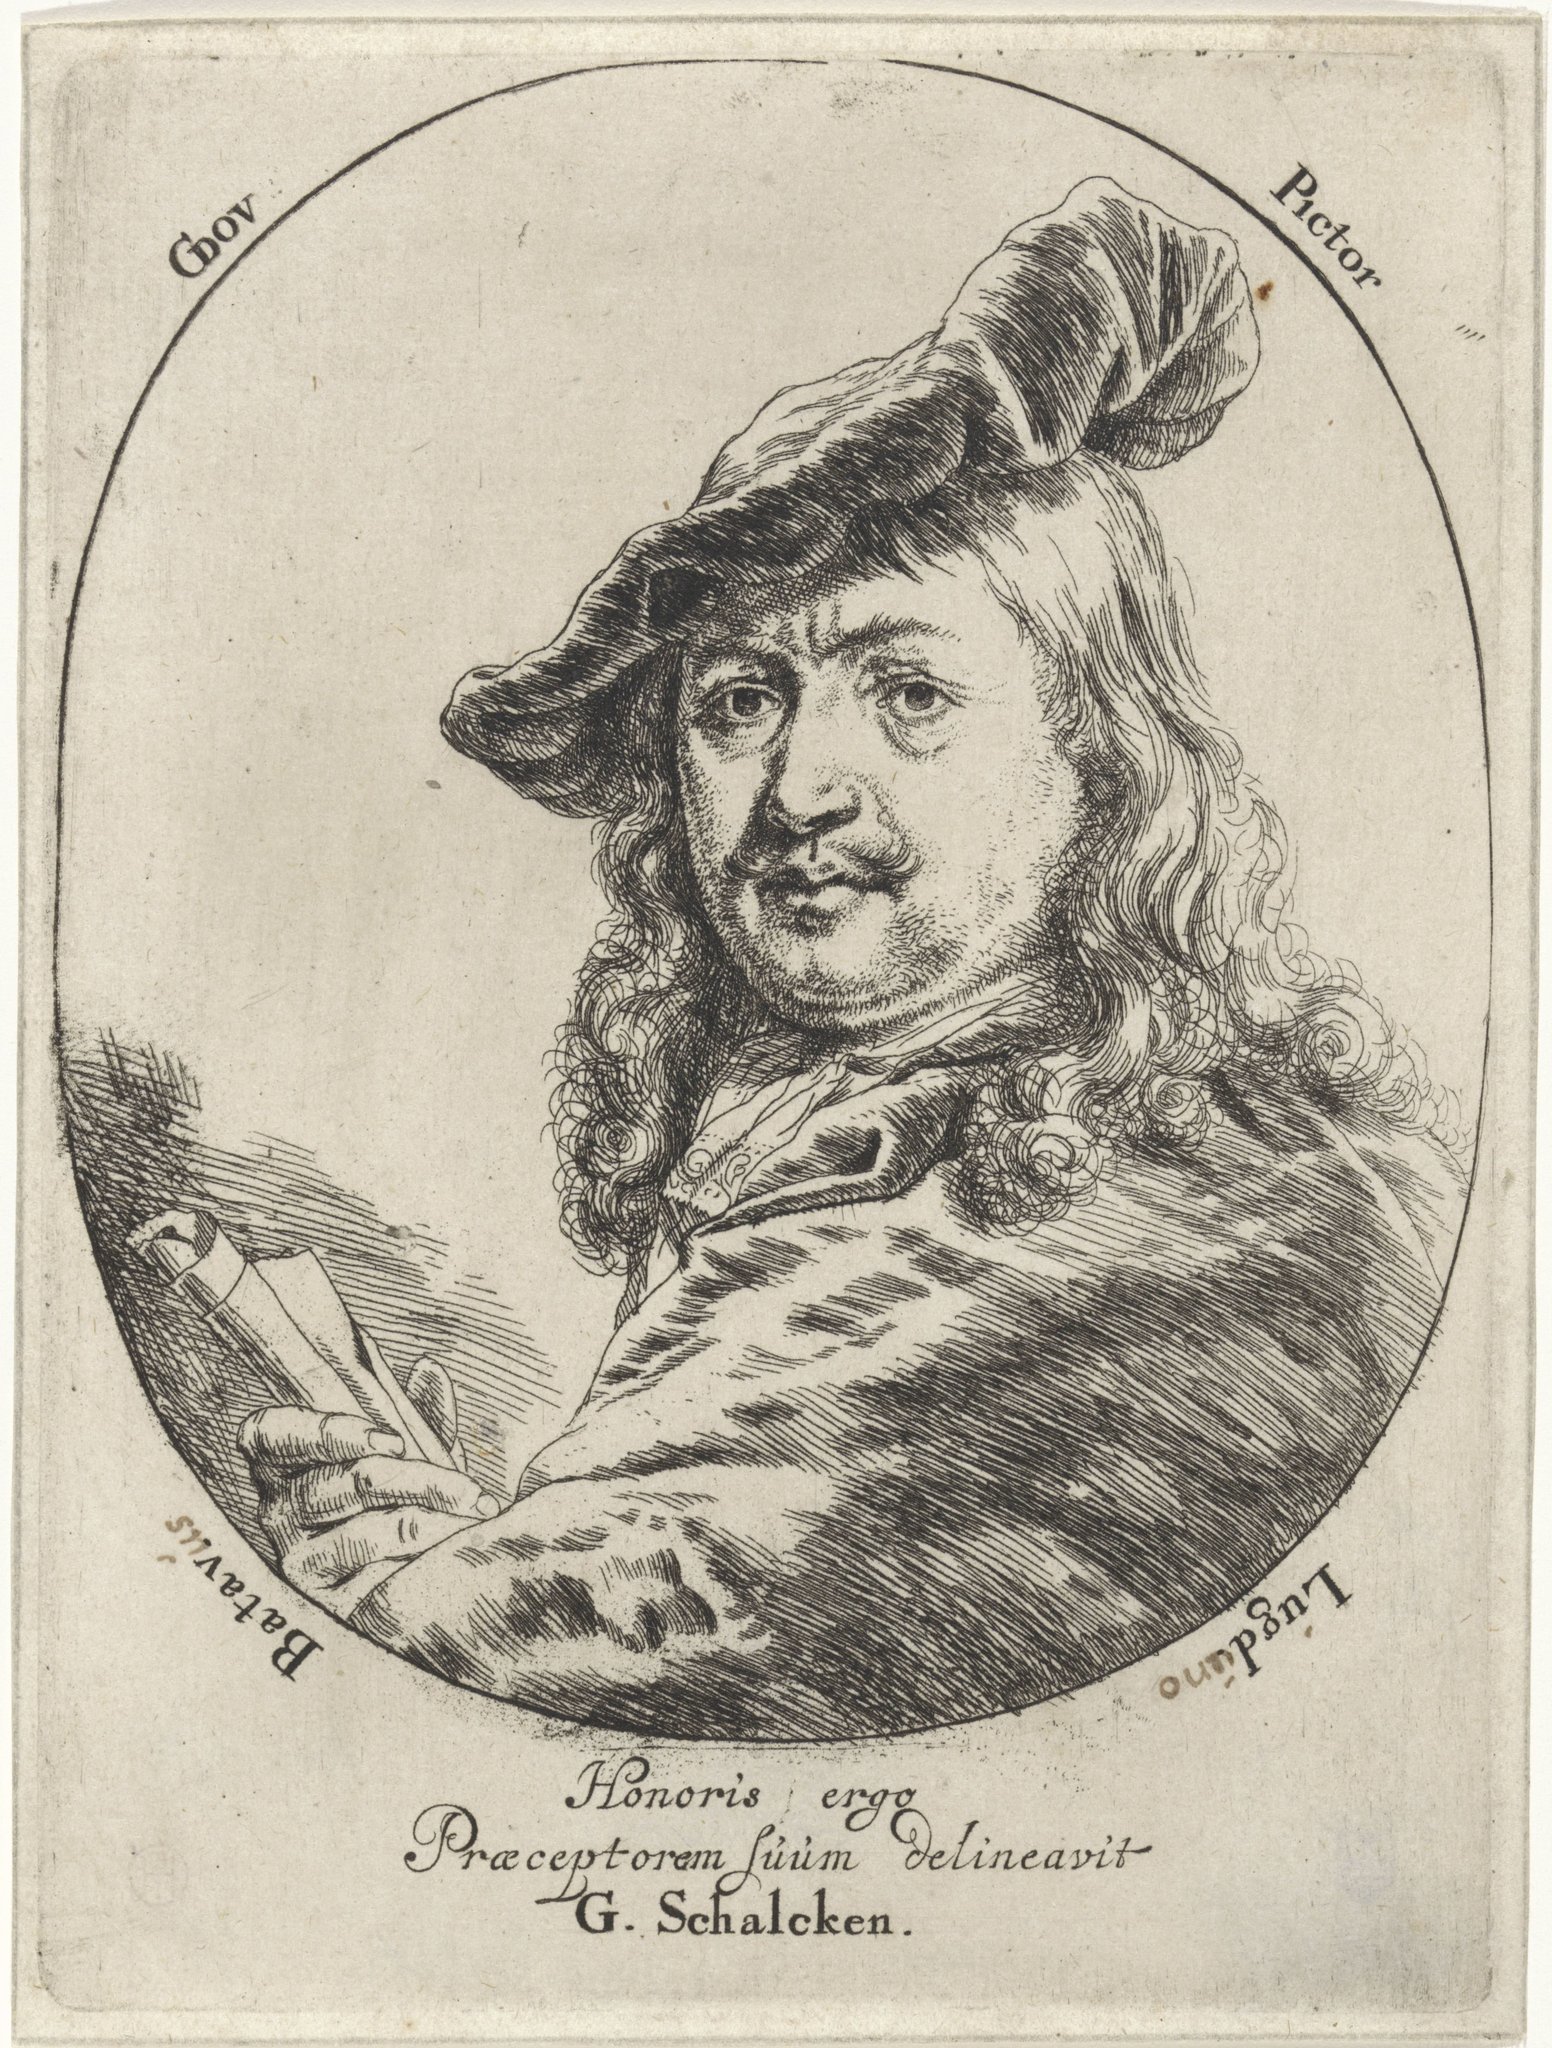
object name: print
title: Portret van Gerard Dou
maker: godfried schalcken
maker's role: draughtsman, painter, print maker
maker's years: 1643-1706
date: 1660-1680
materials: paper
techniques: etching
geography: leiden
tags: leiden, gerard dou, portrait, self-portrait of painter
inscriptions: collector's mark: Lugt 533b, collector's mark: Lugt 2760, collector's mark: Lugt 2612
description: Buste van de kunstenaar Gerard Dou in een ovale omlijsting. Dou draagt een baret en houdt een opgerold stuk papier vast. Rondom de lijst de Latijnse vertaling van: G. Dou, schilder, Leiden. Onder het portret de Latijnse vertaling van: Ter ere van zijn leraar heeft G. Schalcken getekend.